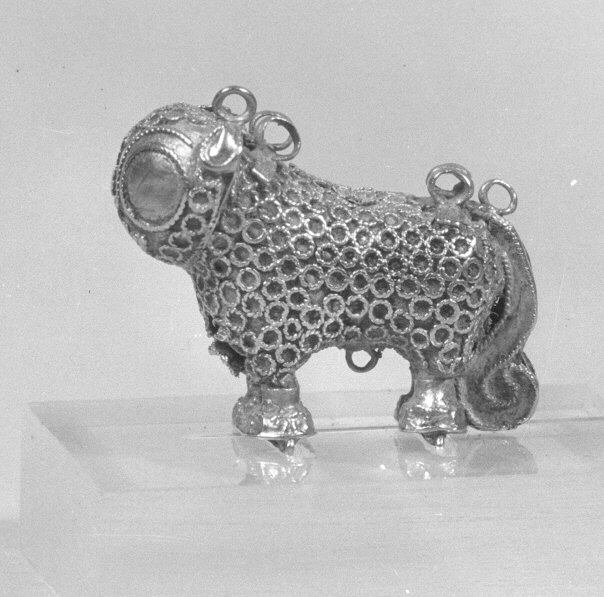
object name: pendant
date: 1101-1200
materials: gold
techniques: filigree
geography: iran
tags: pendants